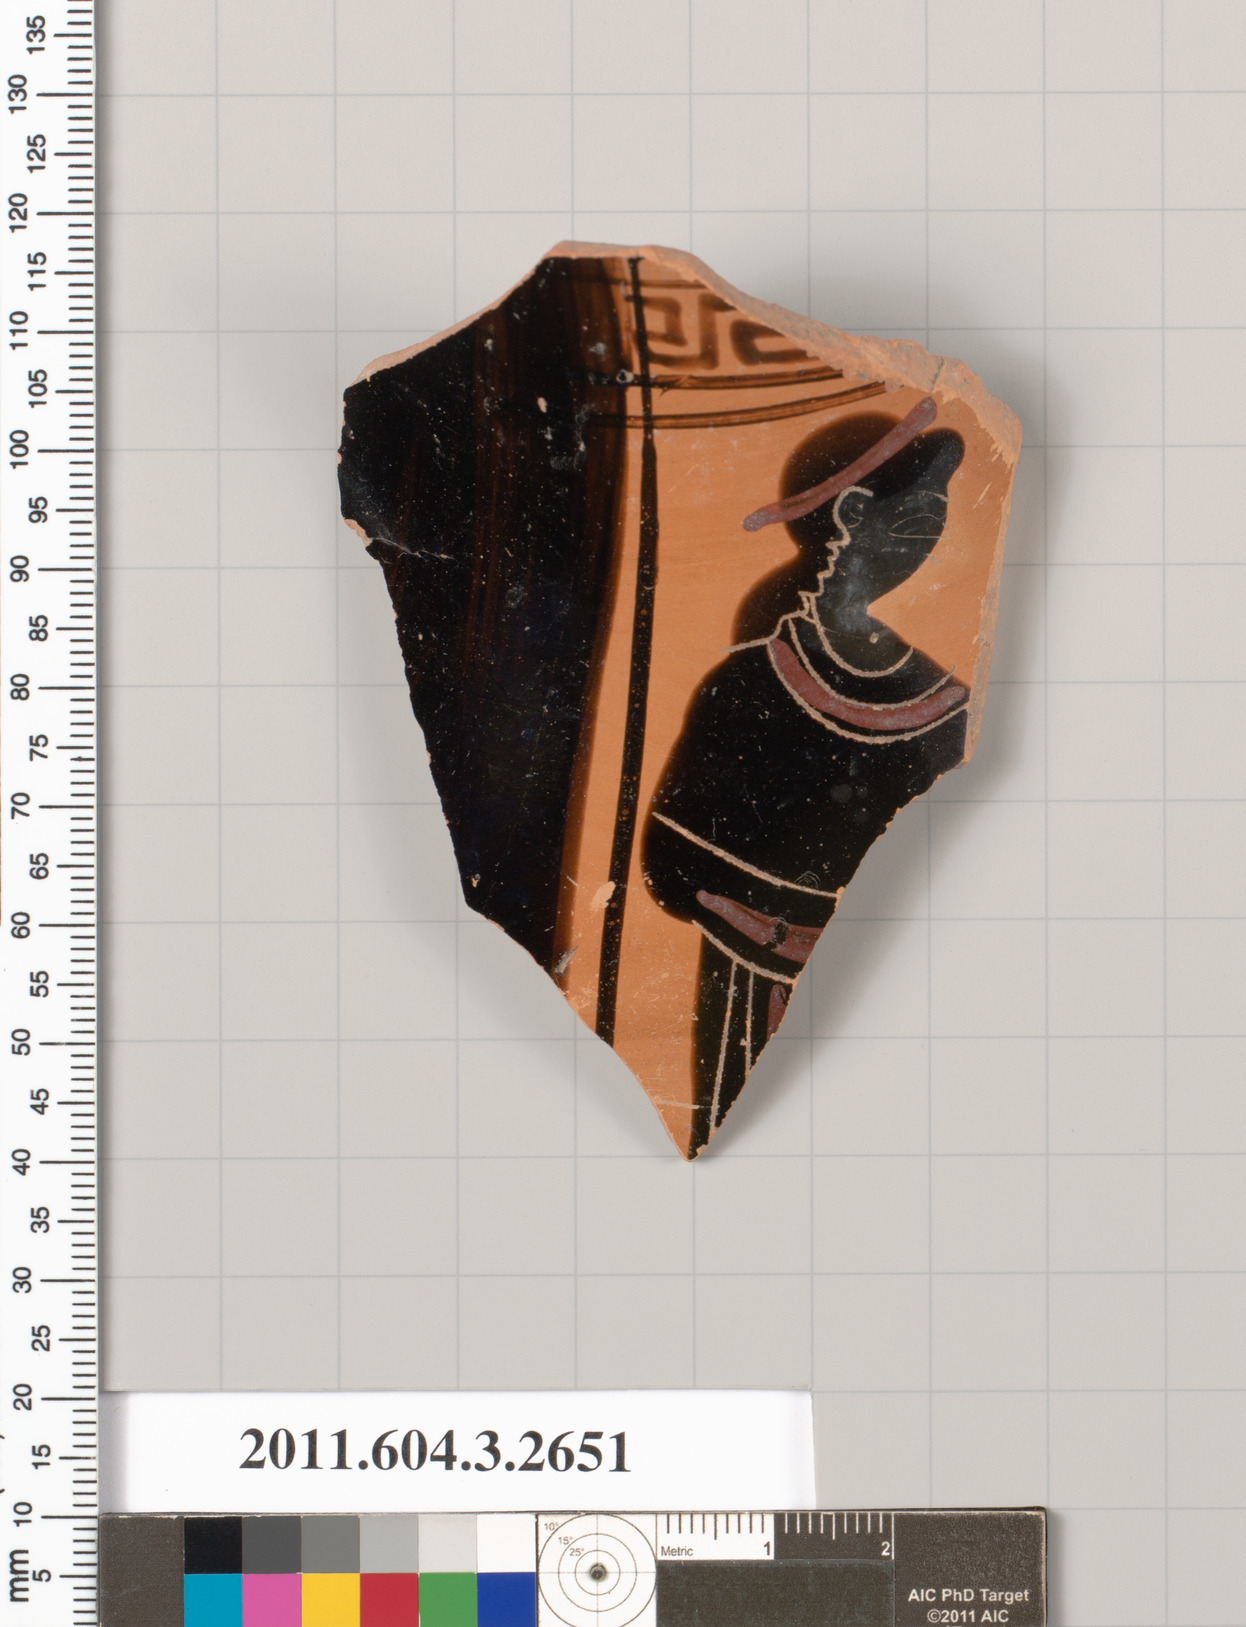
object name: olpe fragment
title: Terracotta fragment of an olpe (jug)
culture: greek, attic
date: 510-500 BCE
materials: terracotta